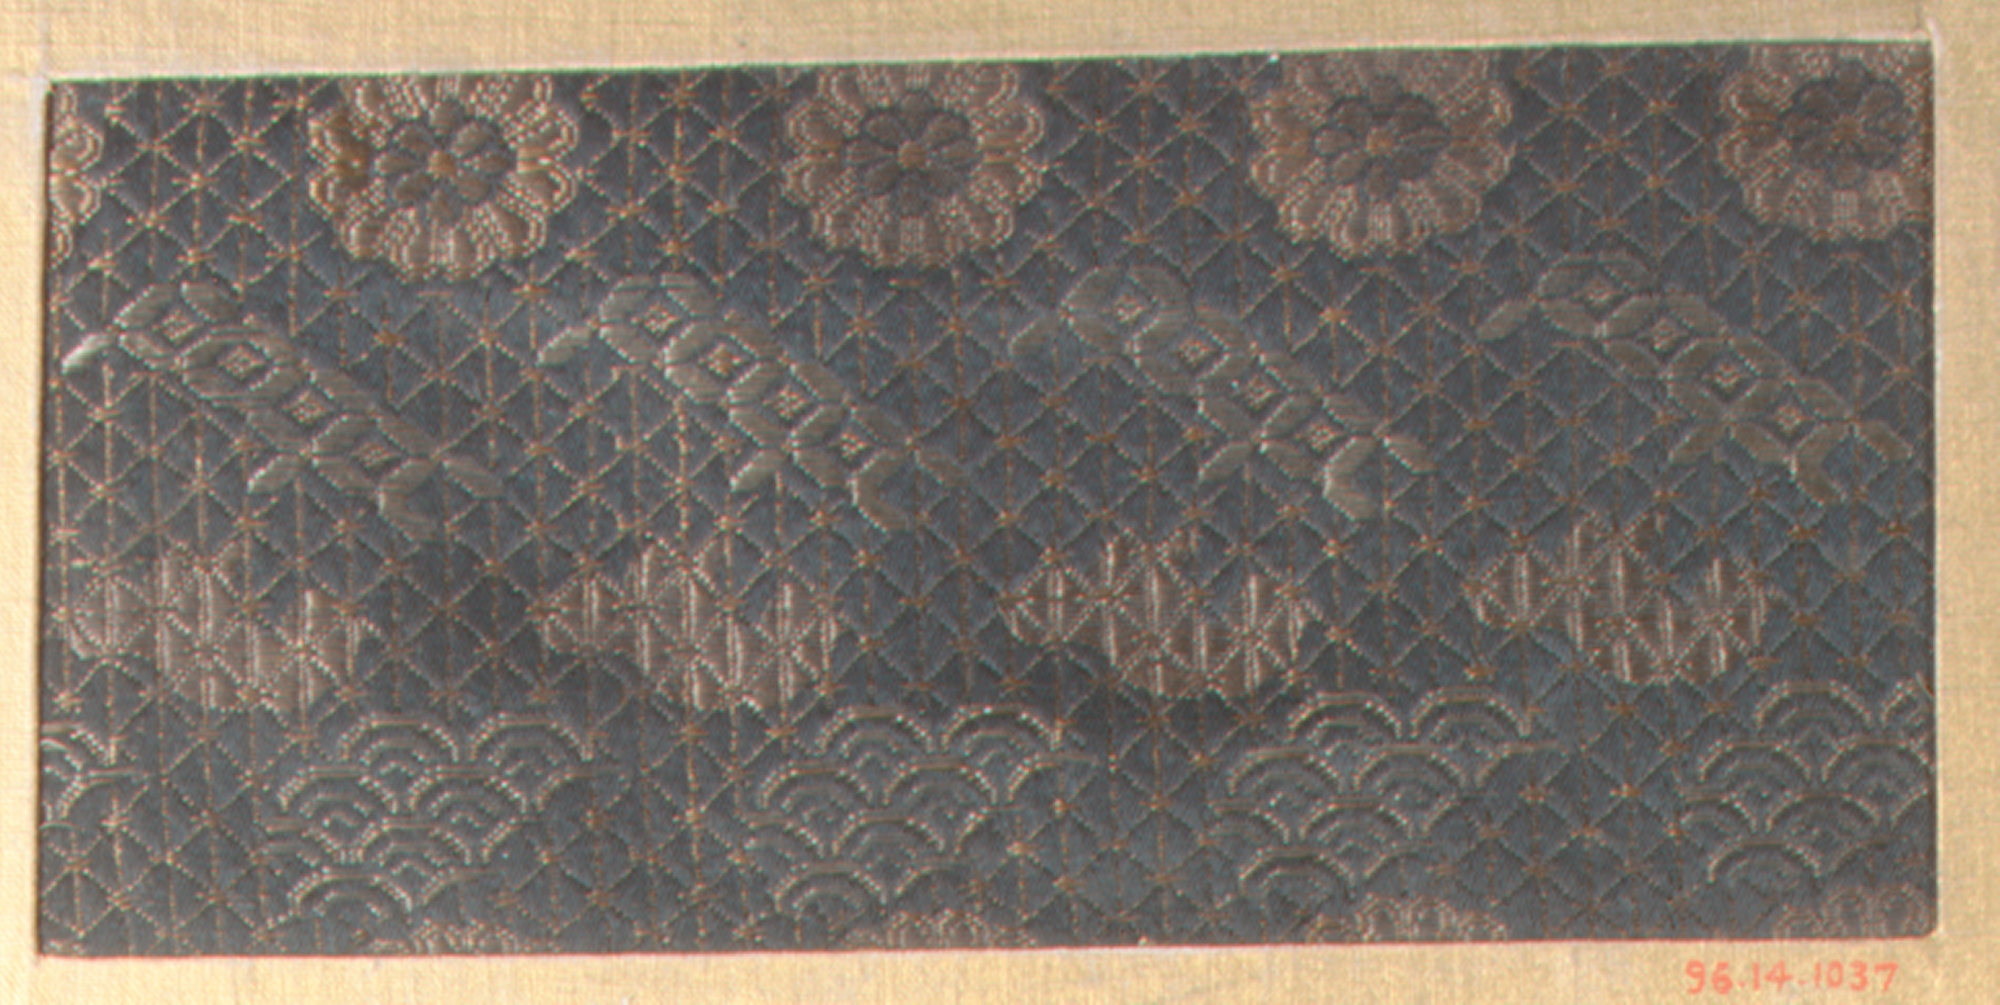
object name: piece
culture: japanese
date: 1701-1900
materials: silk